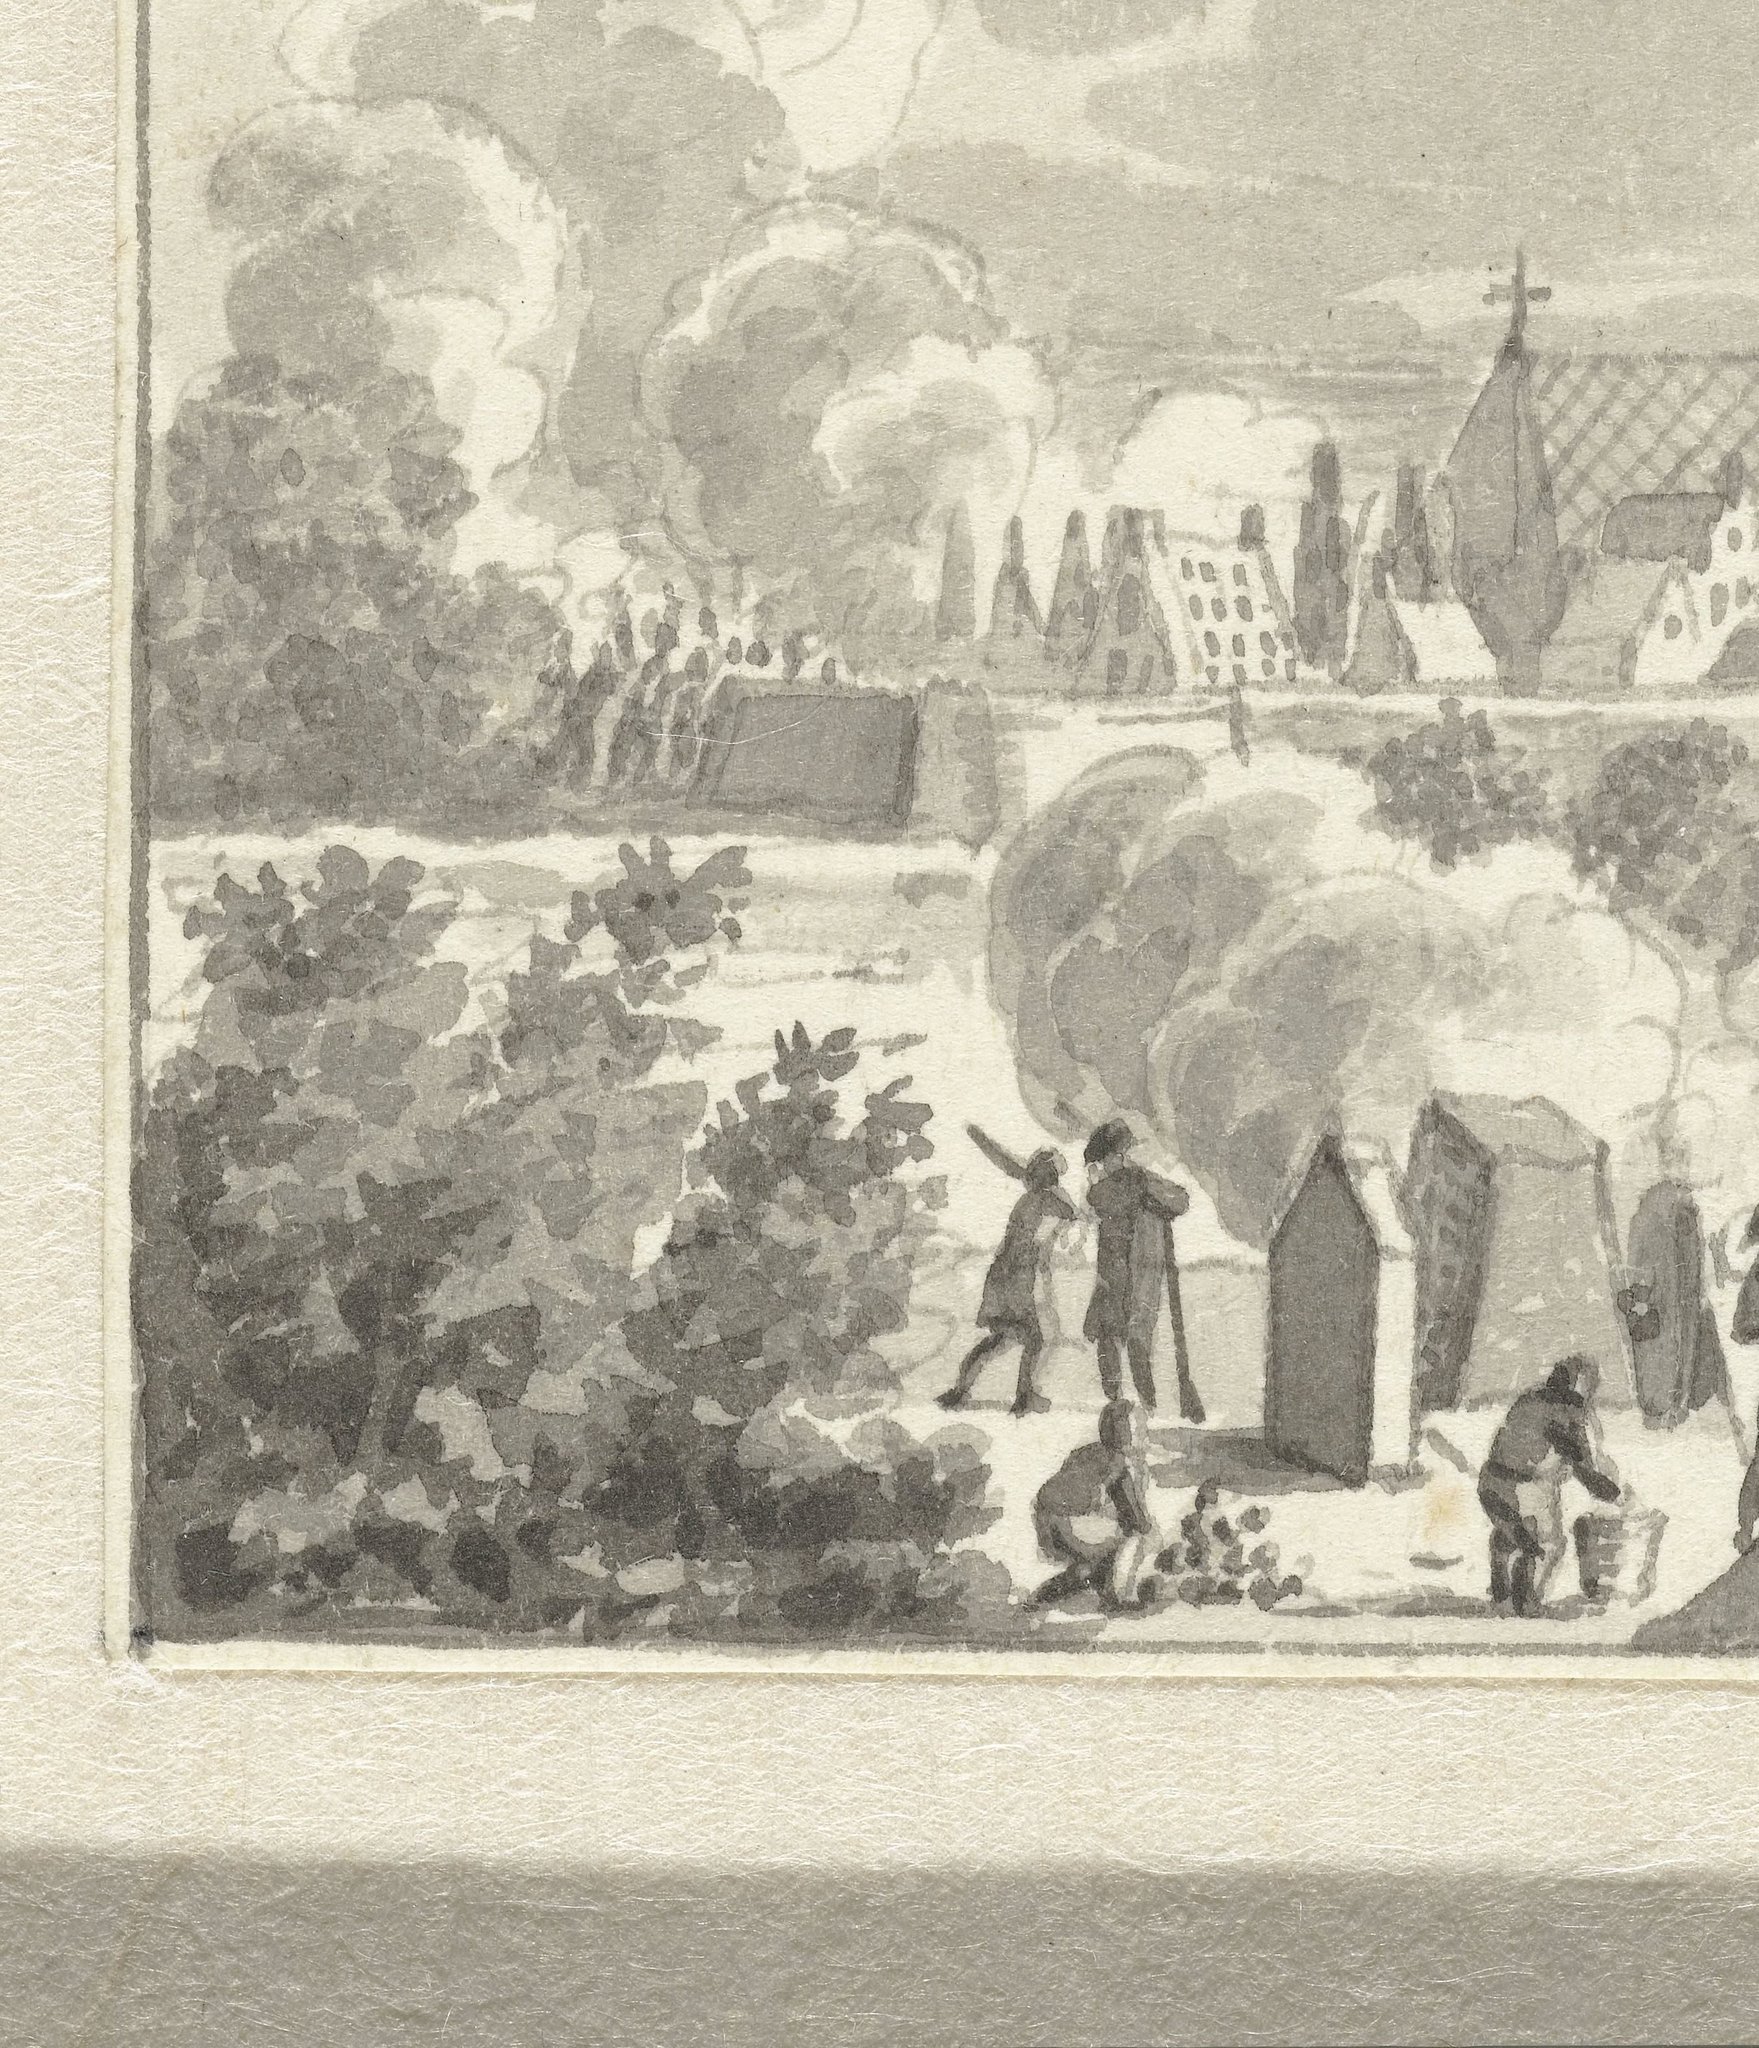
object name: drawing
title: In 't Jaar 1786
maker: Anonymous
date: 1789-1810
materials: ink, paper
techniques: brush, pen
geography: netherlands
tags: bombardment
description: Beschieting van de stad Hattem door de stadhouderlijke troepen, 5 september 1786.